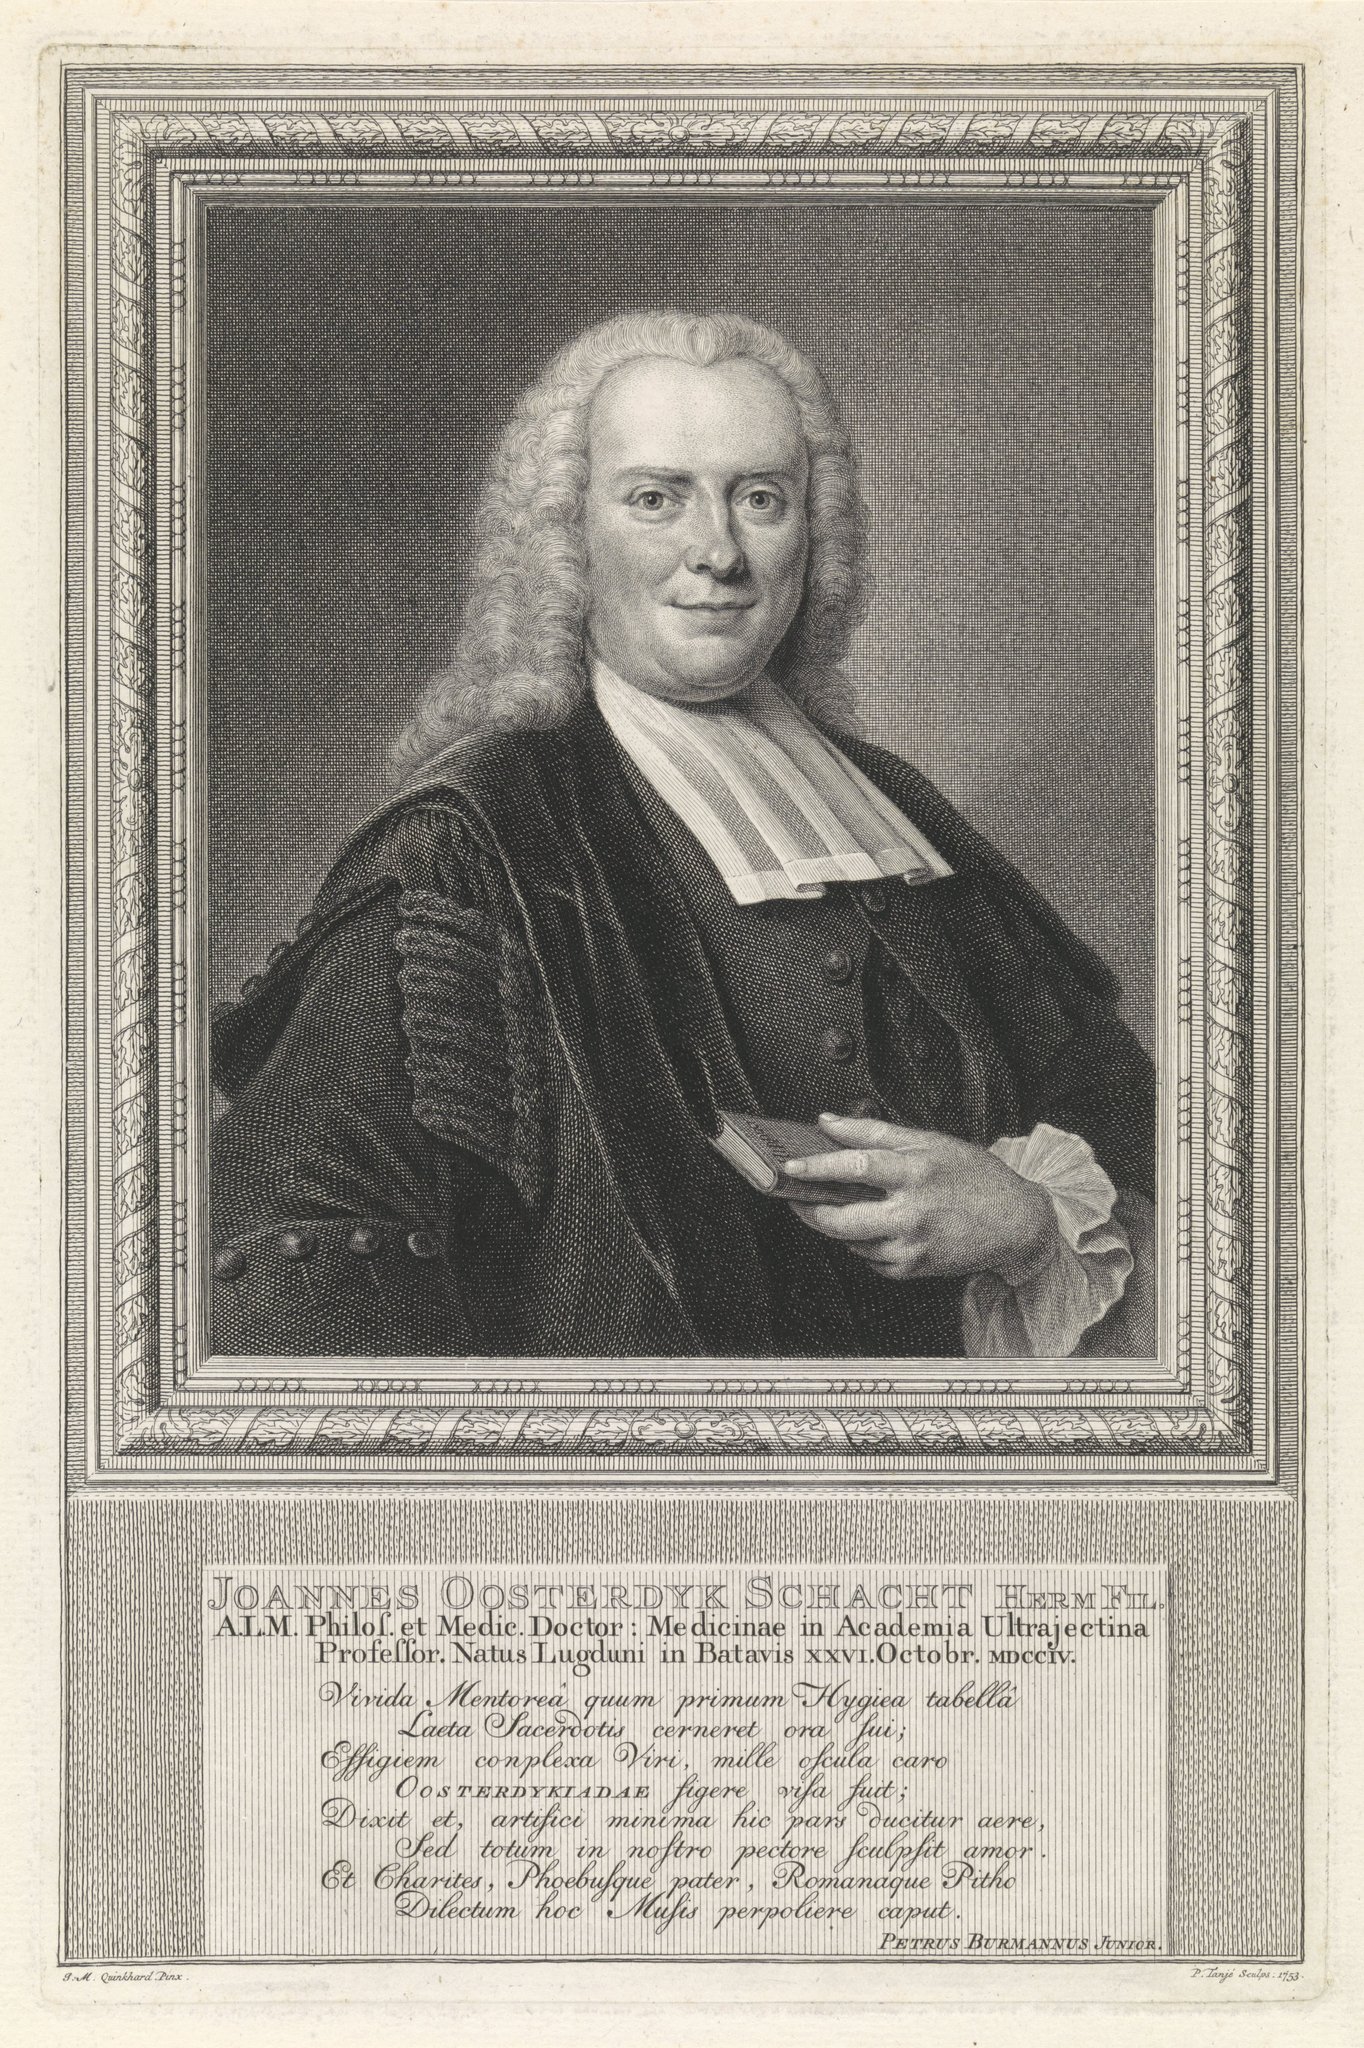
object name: print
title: Portret van Johannes Oosterdijk Schacht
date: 1753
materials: paper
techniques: engraving, etching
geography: amsterdam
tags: hoogleraar, johannes oosterdijk schacht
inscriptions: collector's mark: Lugt 2228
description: Johannes Oosterdijk Schacht, filosoof en hoogleraar geneeskunde te Utrecht. Onderaan in de marge een achtregelige tekst in het Latijn.